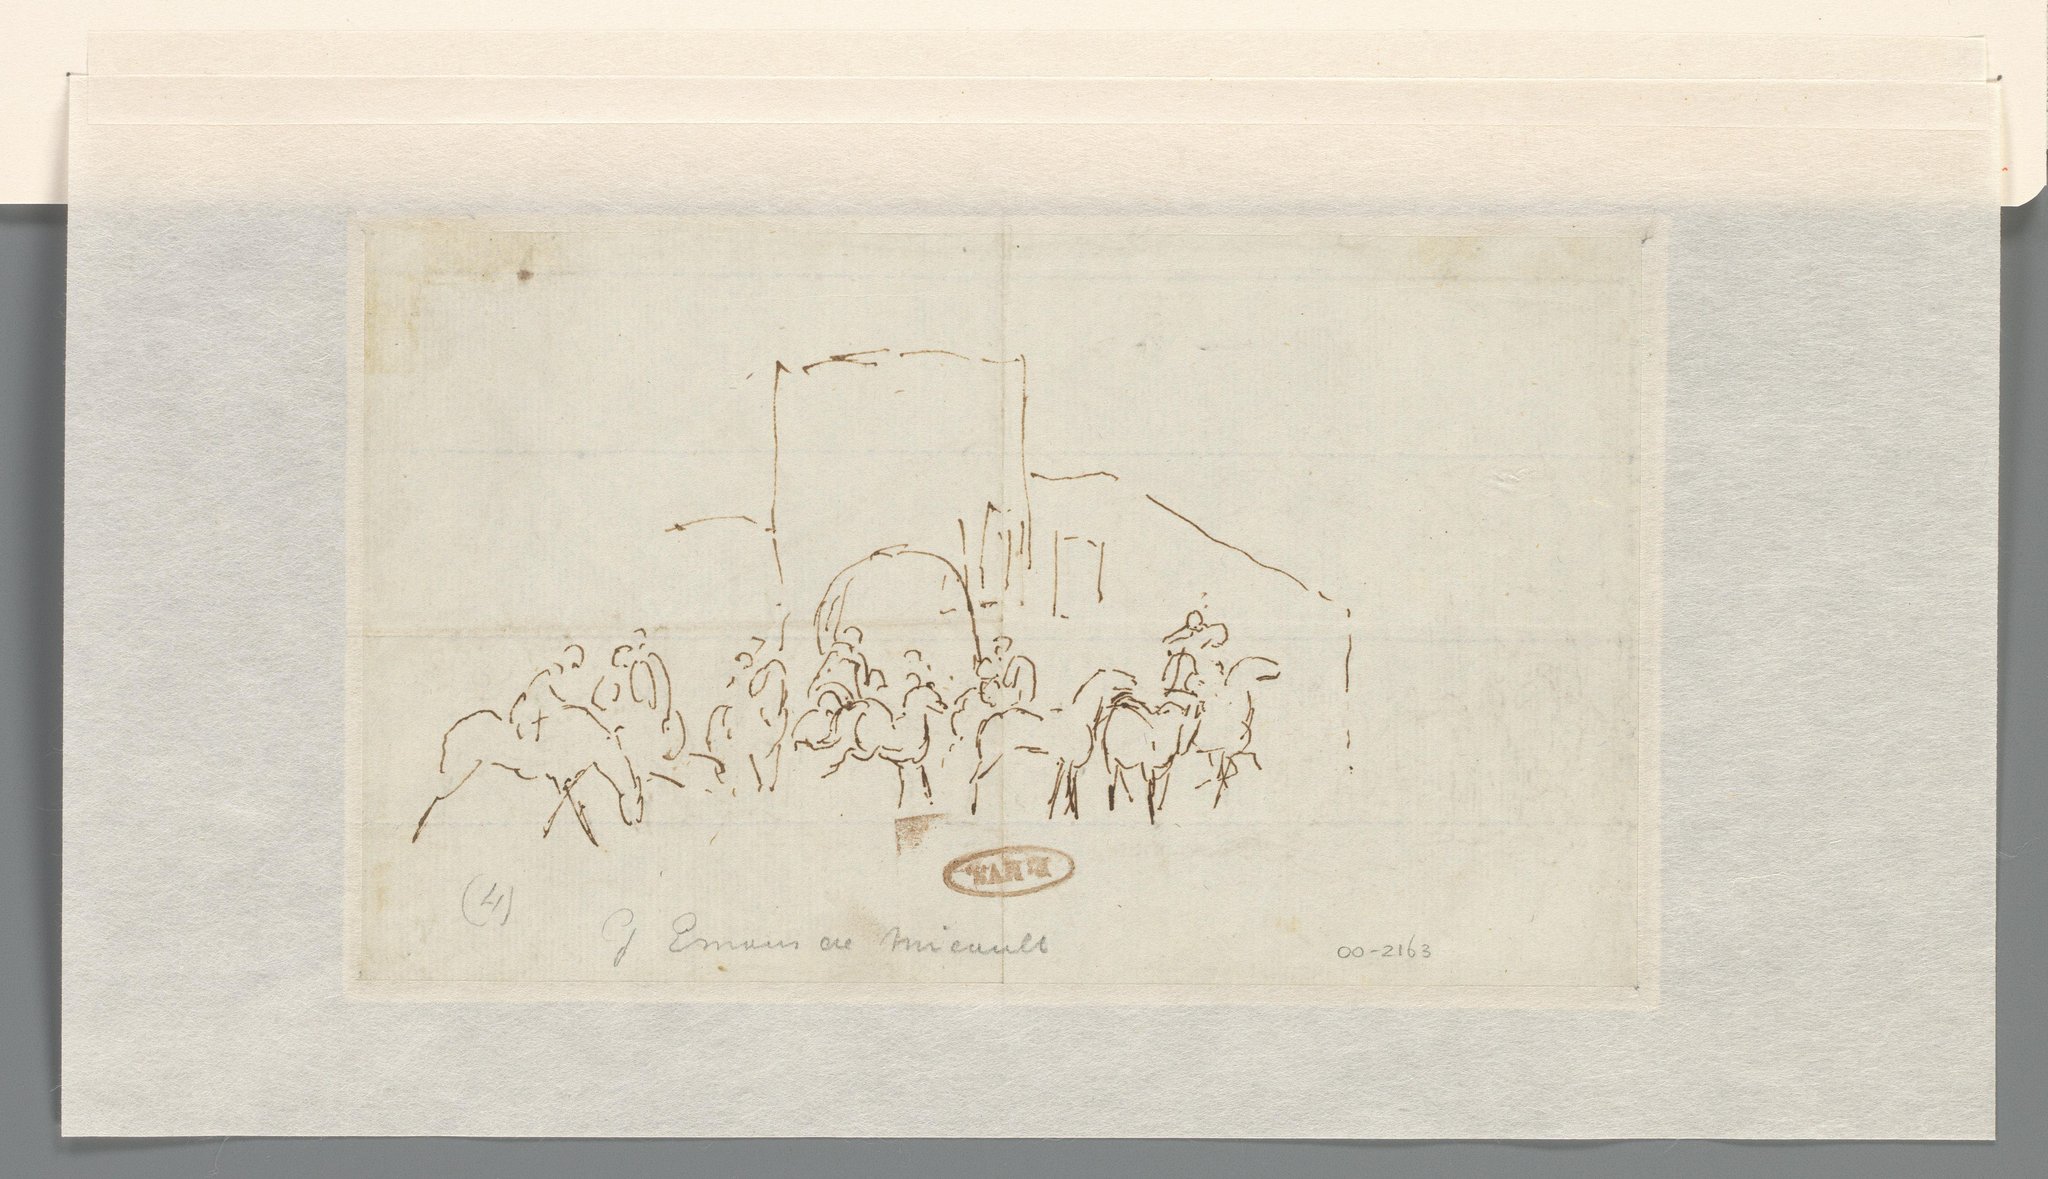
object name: drawing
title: Schets van ruiters bij een poort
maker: gerardus emaus de micault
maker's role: draughtsman, print maker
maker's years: 1798-1863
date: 1799-1863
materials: ink, paper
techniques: pen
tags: land forces (+ cavalry, horsemen)